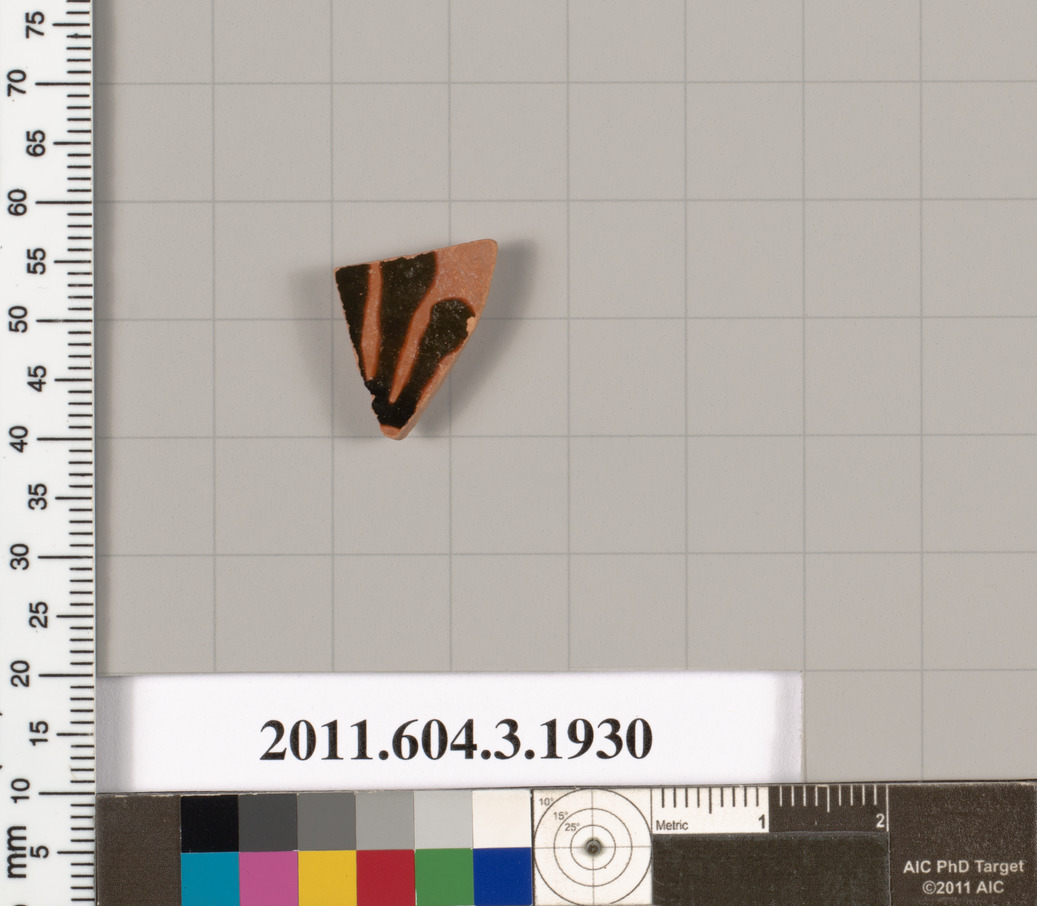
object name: kylix or skyphos fragment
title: Terracotta fragment of a kylix (drinking cup) or a skyphos (deep drinking cup)?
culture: greek, attic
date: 534-468 BCE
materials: terracotta